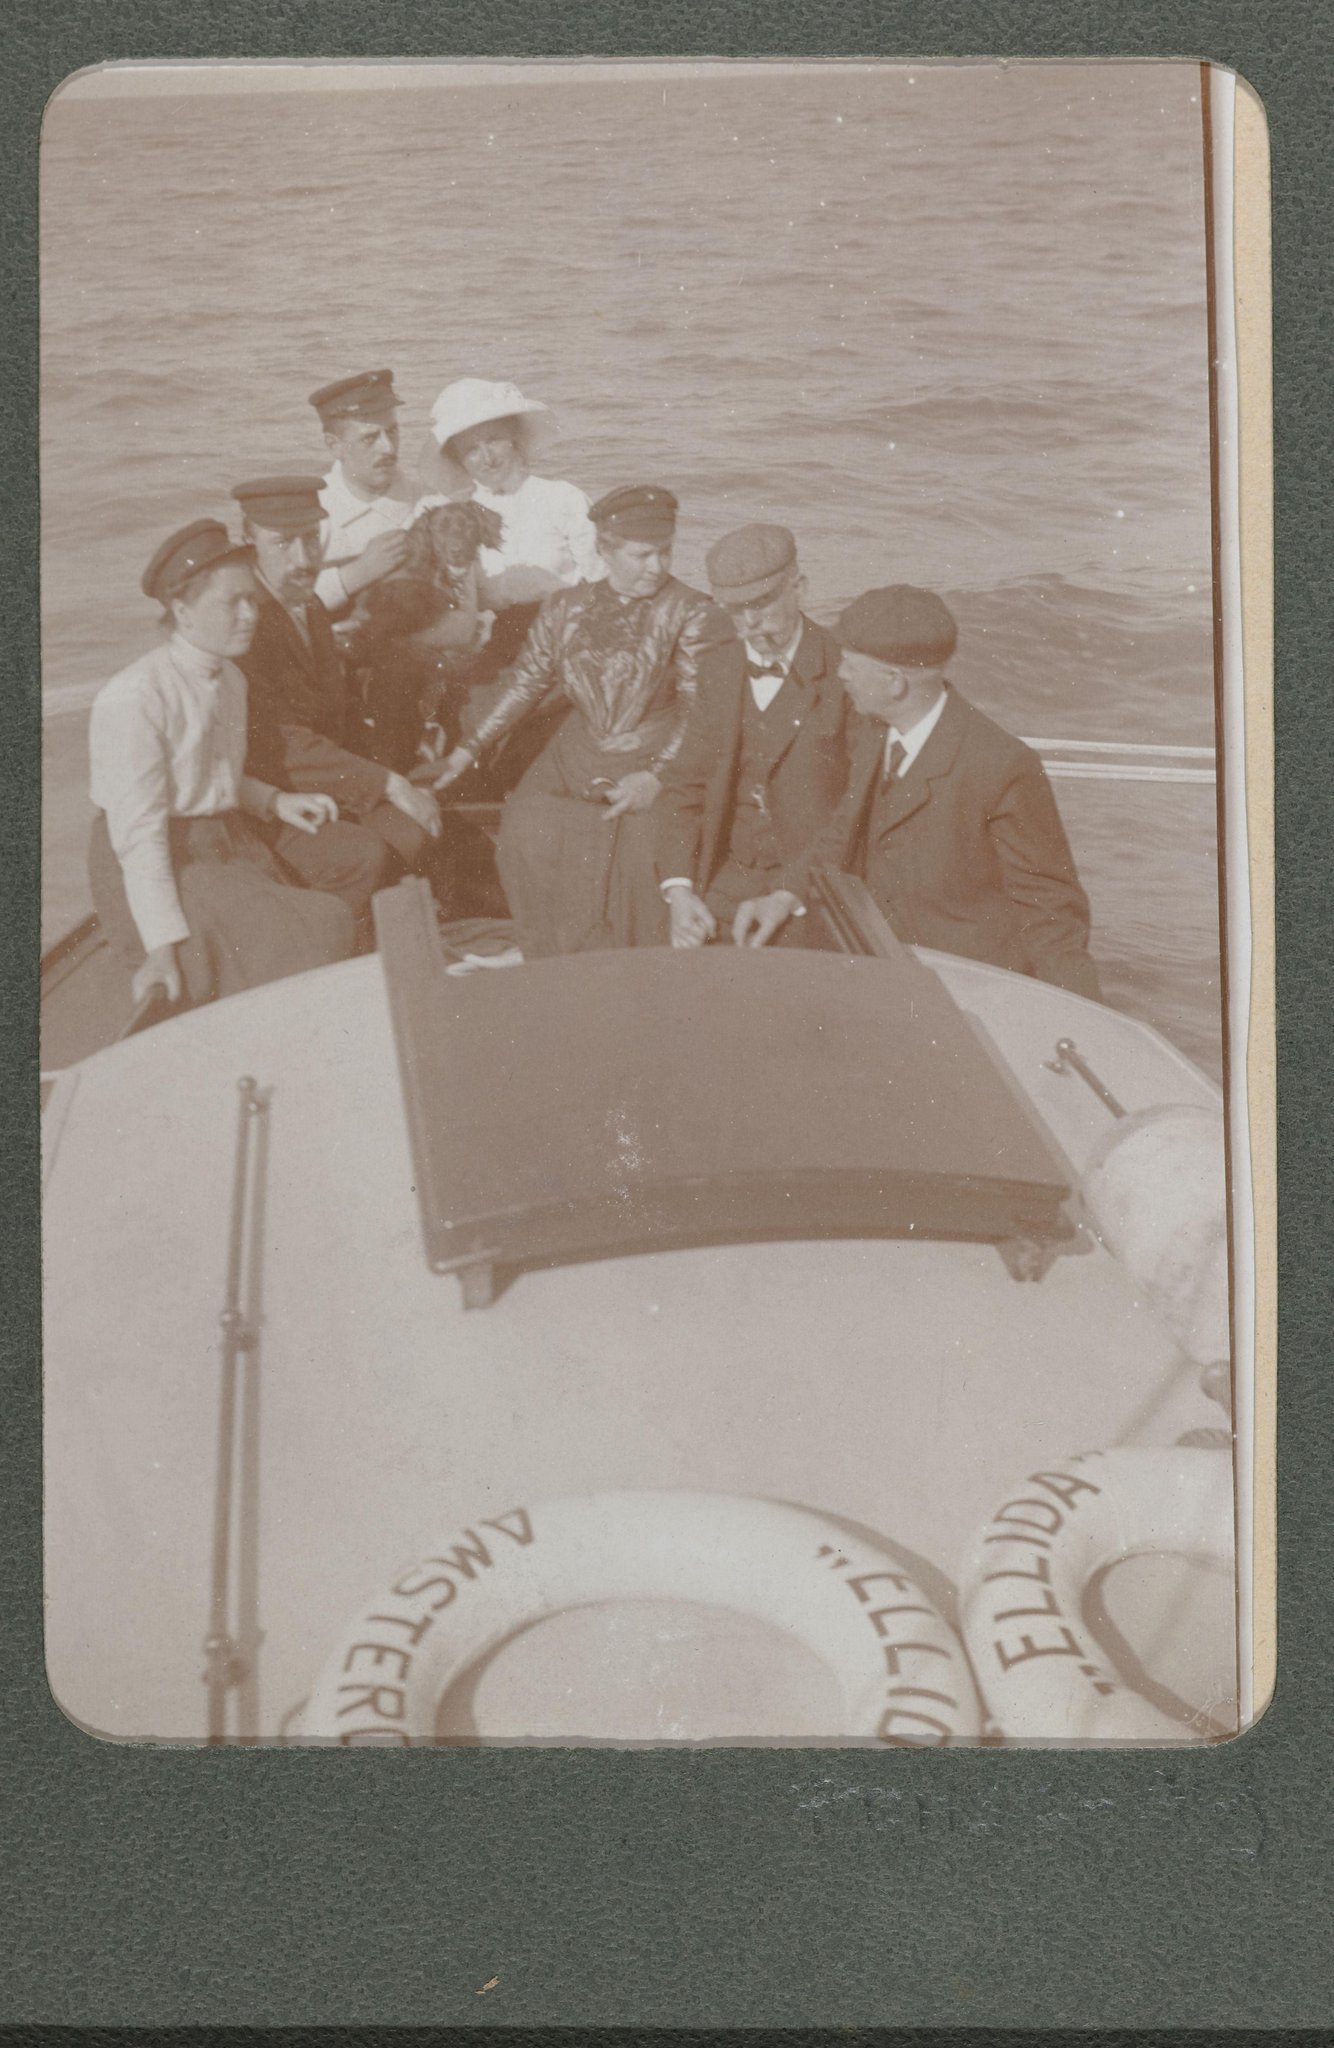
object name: album leaf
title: Gezelschap aan boord van de boot Ellida uit Amsterdam, links zitten Charlotte en Christiaan Otto Roelofs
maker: christiaan otto roelofs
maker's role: fotograaf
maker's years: 1882-1970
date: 1900-1915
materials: photographic support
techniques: collodion silver print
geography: netherlands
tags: amsterdam, christiaan otto roelofs, historical persons, traffic on the water, loose company